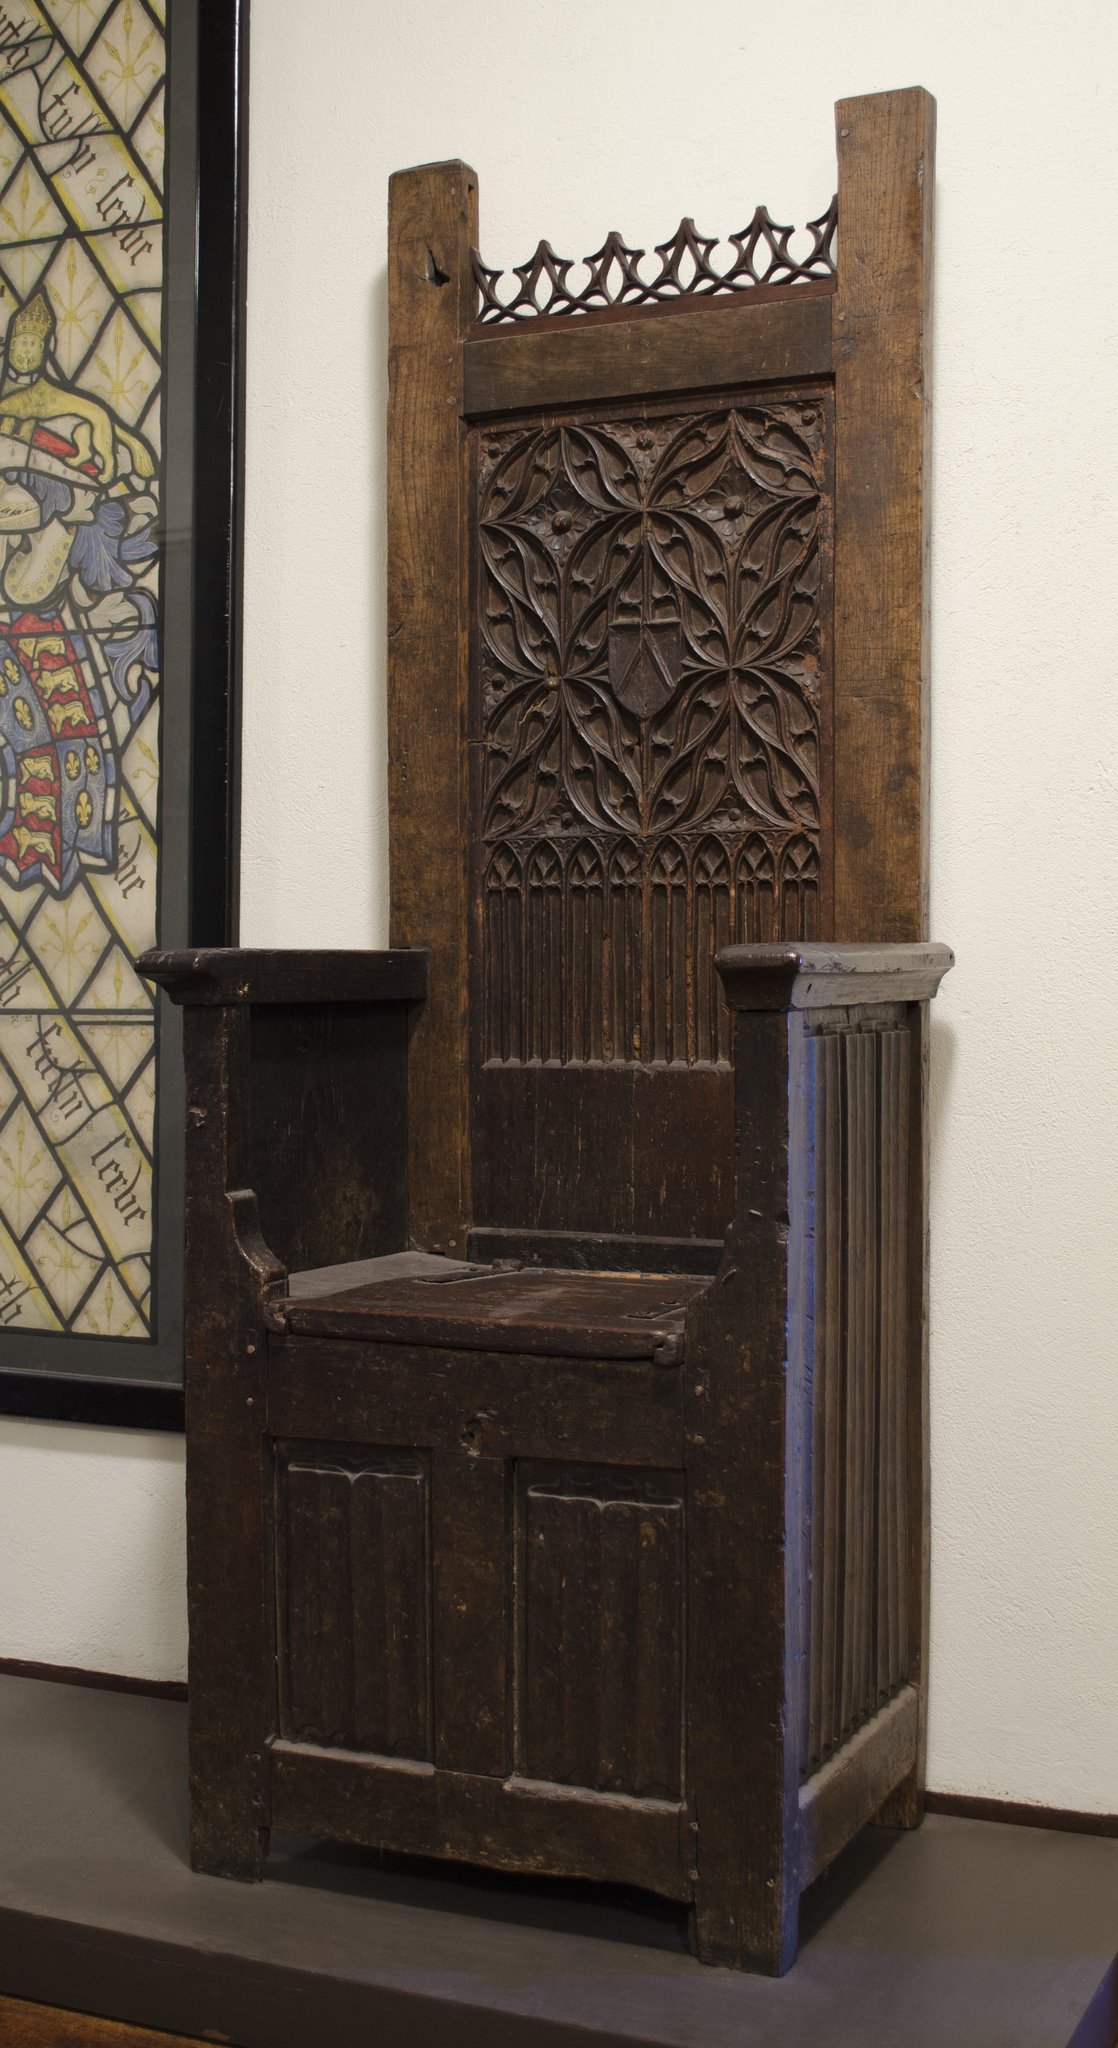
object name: chair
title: High-Backed Chair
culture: french or south netherlandish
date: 1401-1500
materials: wood